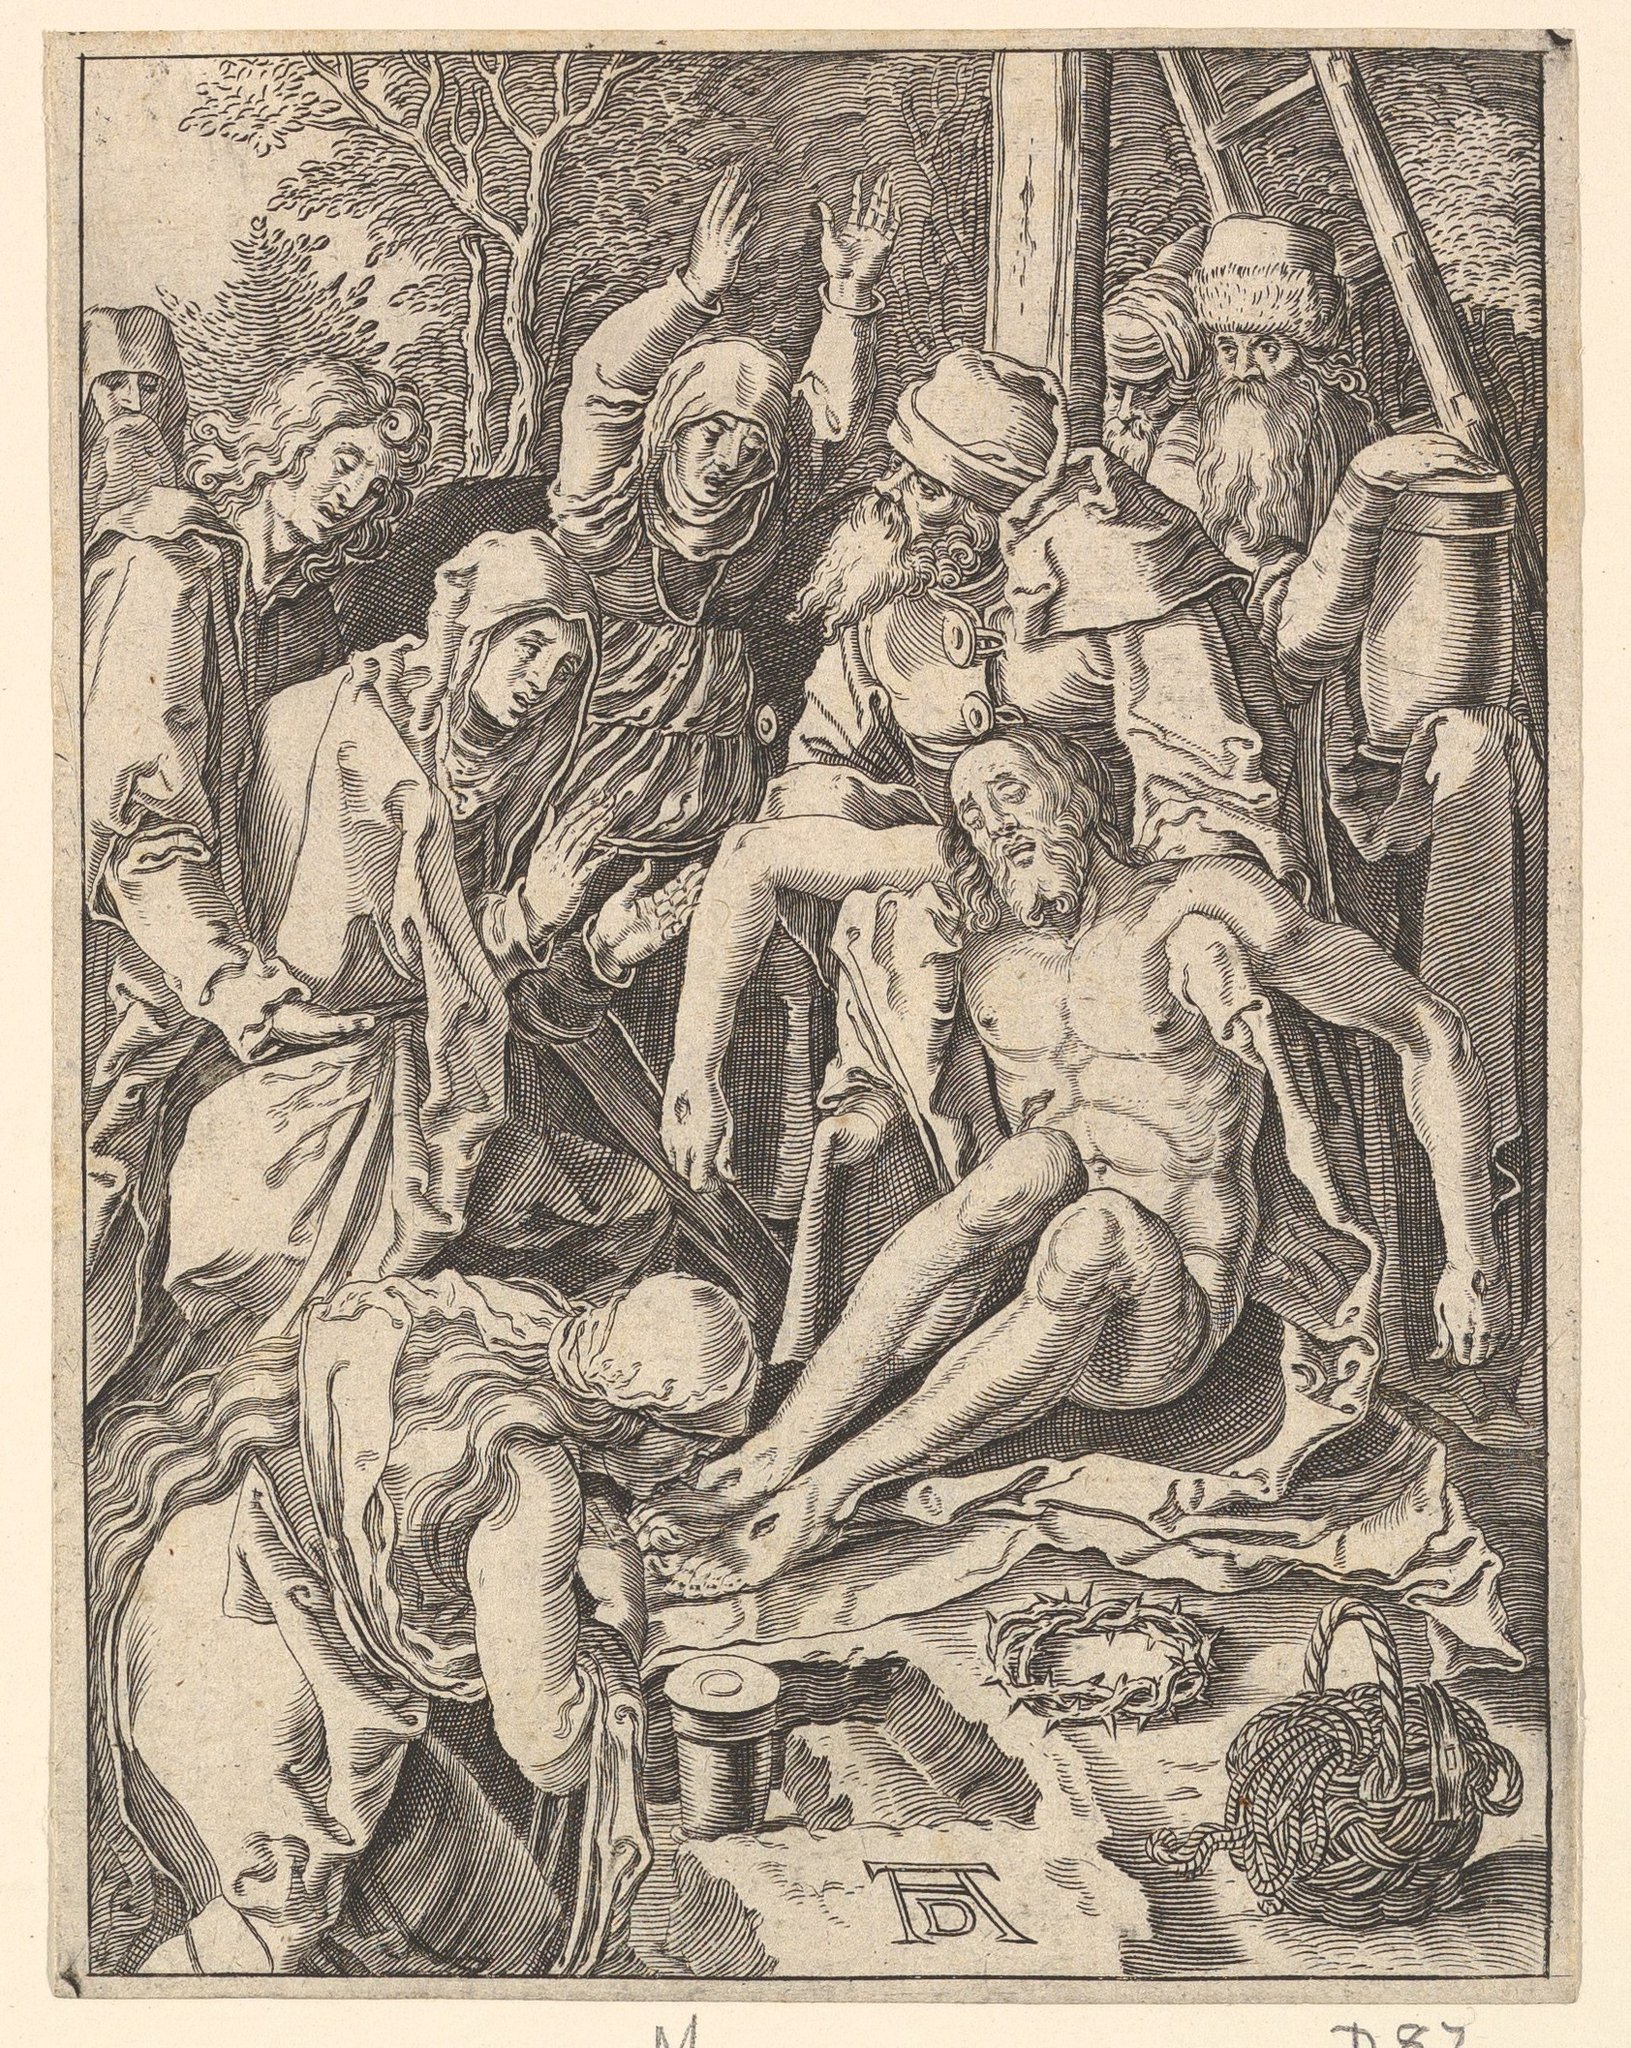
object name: print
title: Engraved copies of The Little Passion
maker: albrecht dürer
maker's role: artist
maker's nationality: german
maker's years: 1471-1528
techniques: engraving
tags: suffering,men,women,jesus